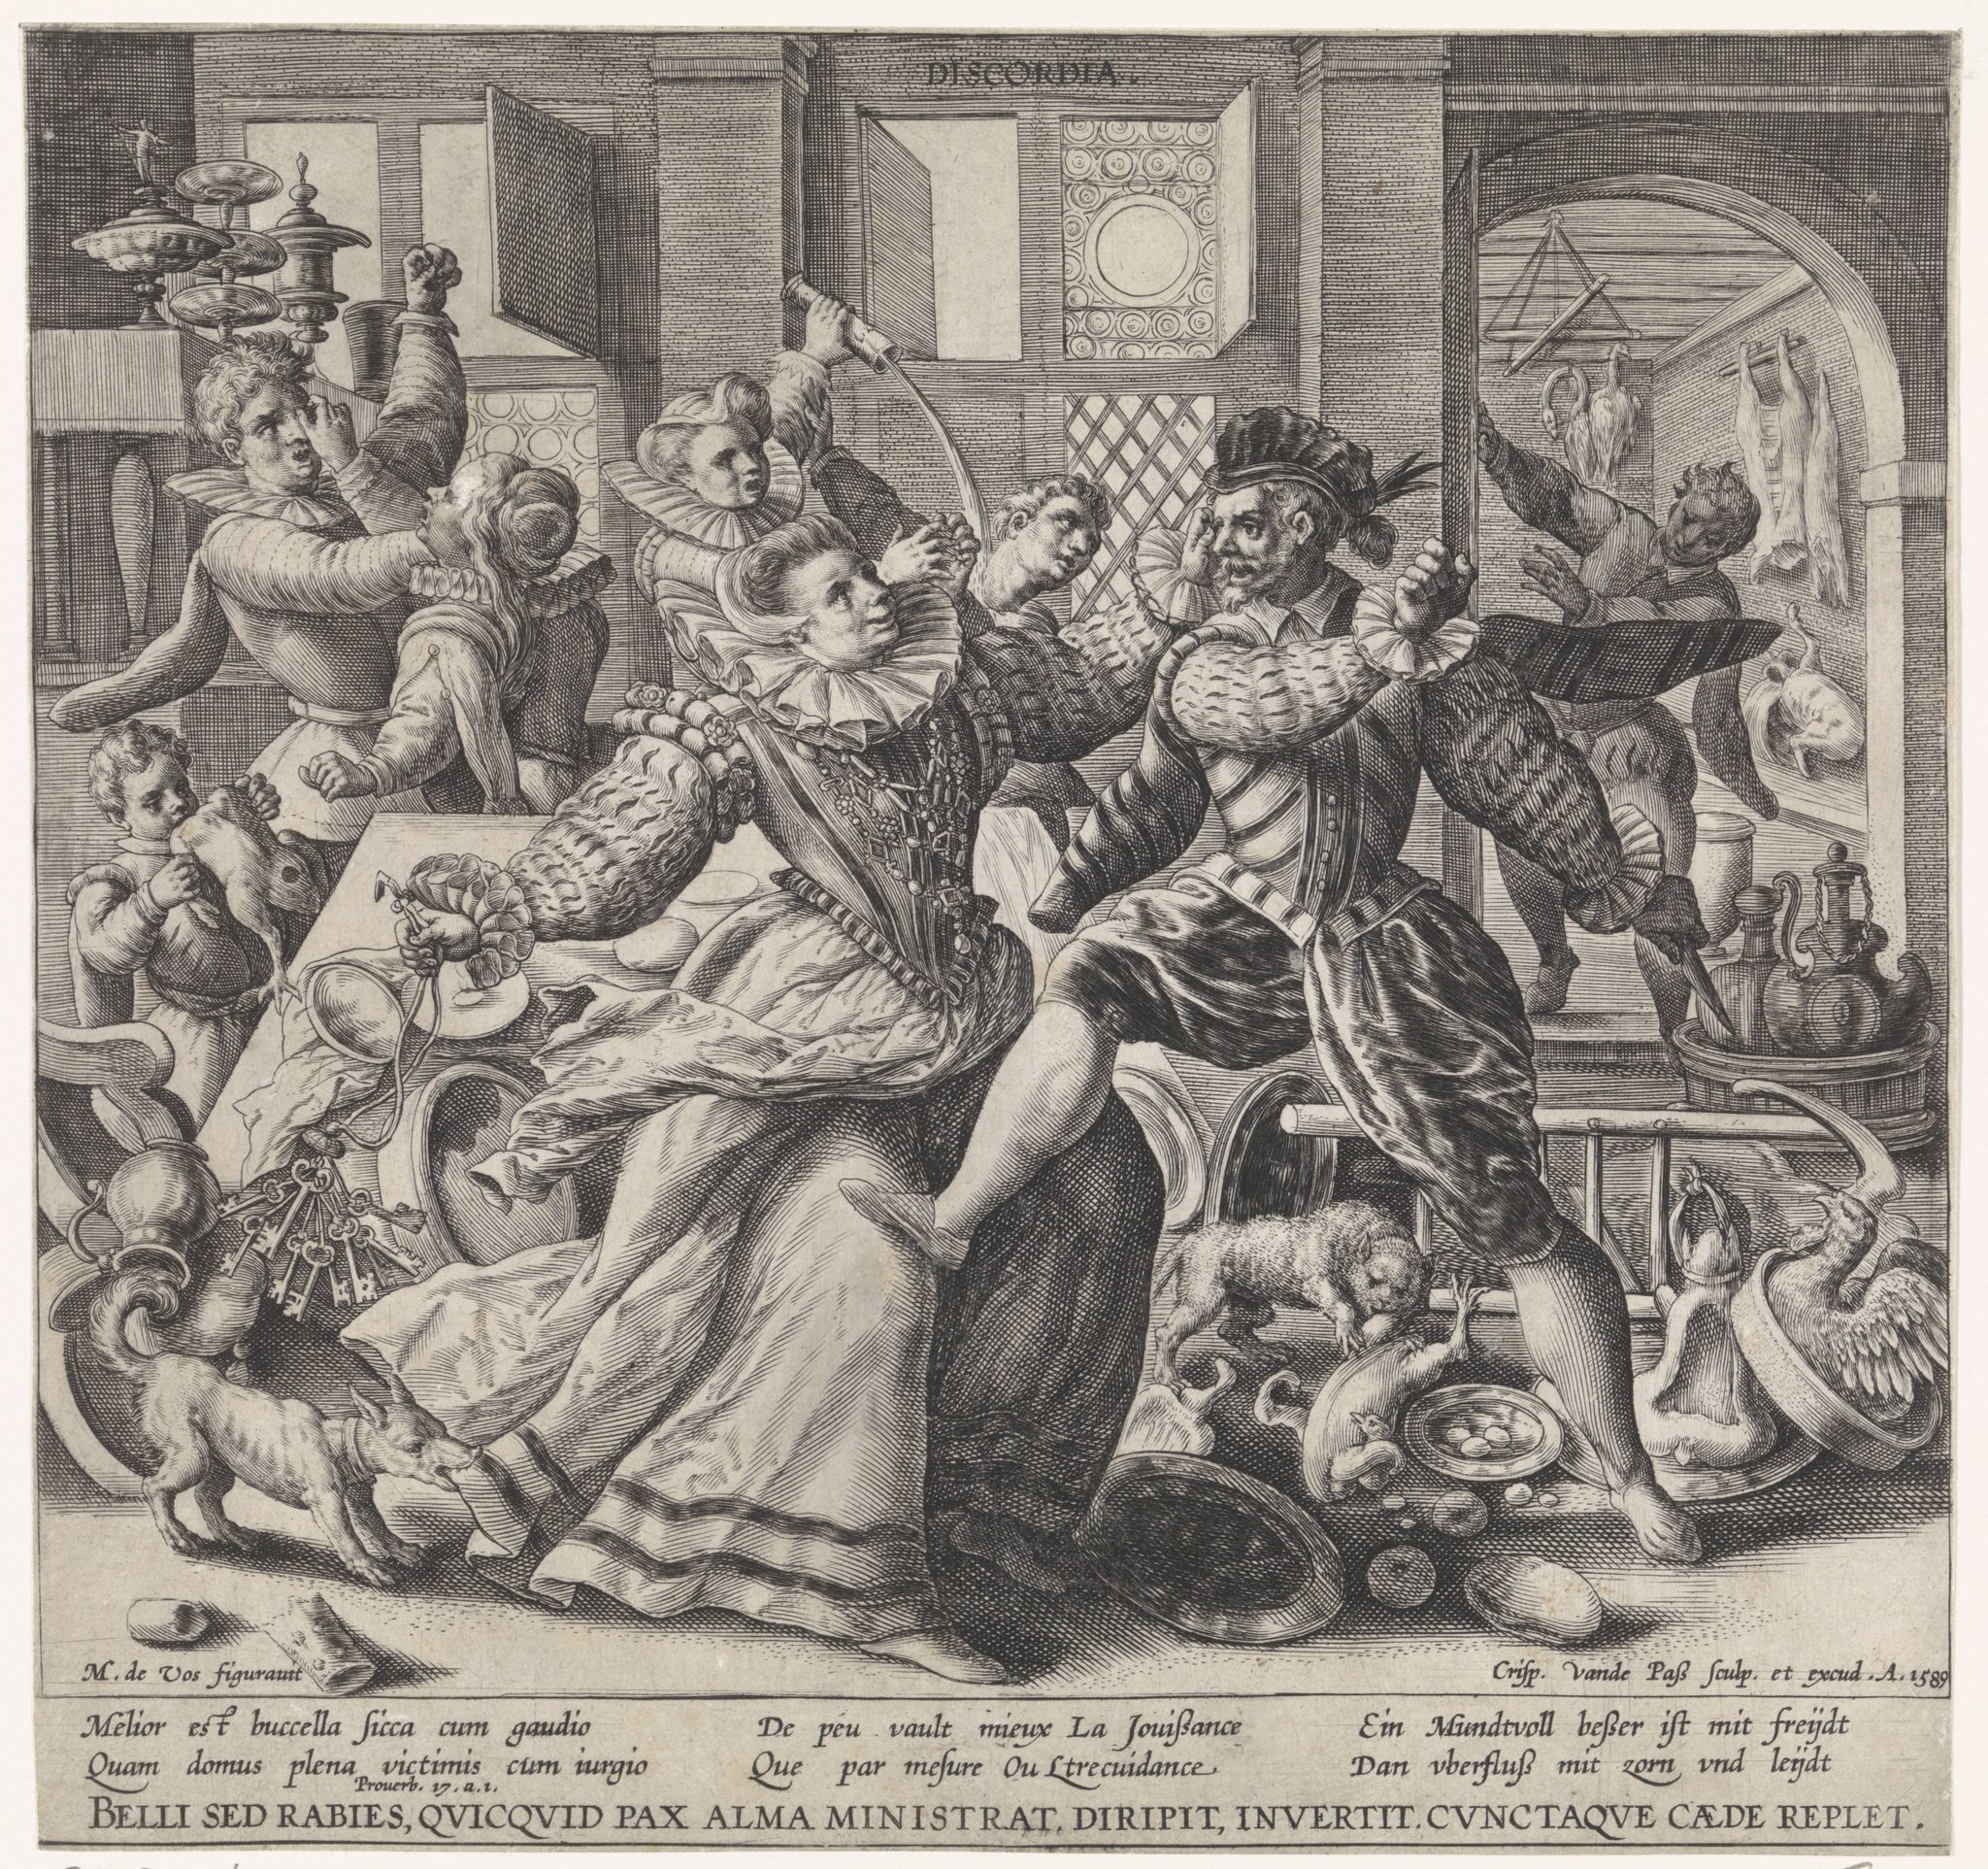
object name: print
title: Discordia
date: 1589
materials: paper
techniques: engraving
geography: cologne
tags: disagreement, discord; 'discordia' (ripa), fighting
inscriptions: collector's mark: Lugt 2228, collector's mark: Lugt 2760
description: De verbeelding van de ondeugd Tweedracht (Discordia): interieur met drie elegant geklede paren die met elkaar aan het vechten zijn. Allerlei huisraad is op de grond gevallen. Een hond bijt in de jurk van een vrouw. Een kind en een kat nemen een hap van een kalkoen. In de marge een zesregelig Bijbelcitaat uit Spr. 17 en een motto in het Latijn. Pendant van een prent met het goede huishouden.